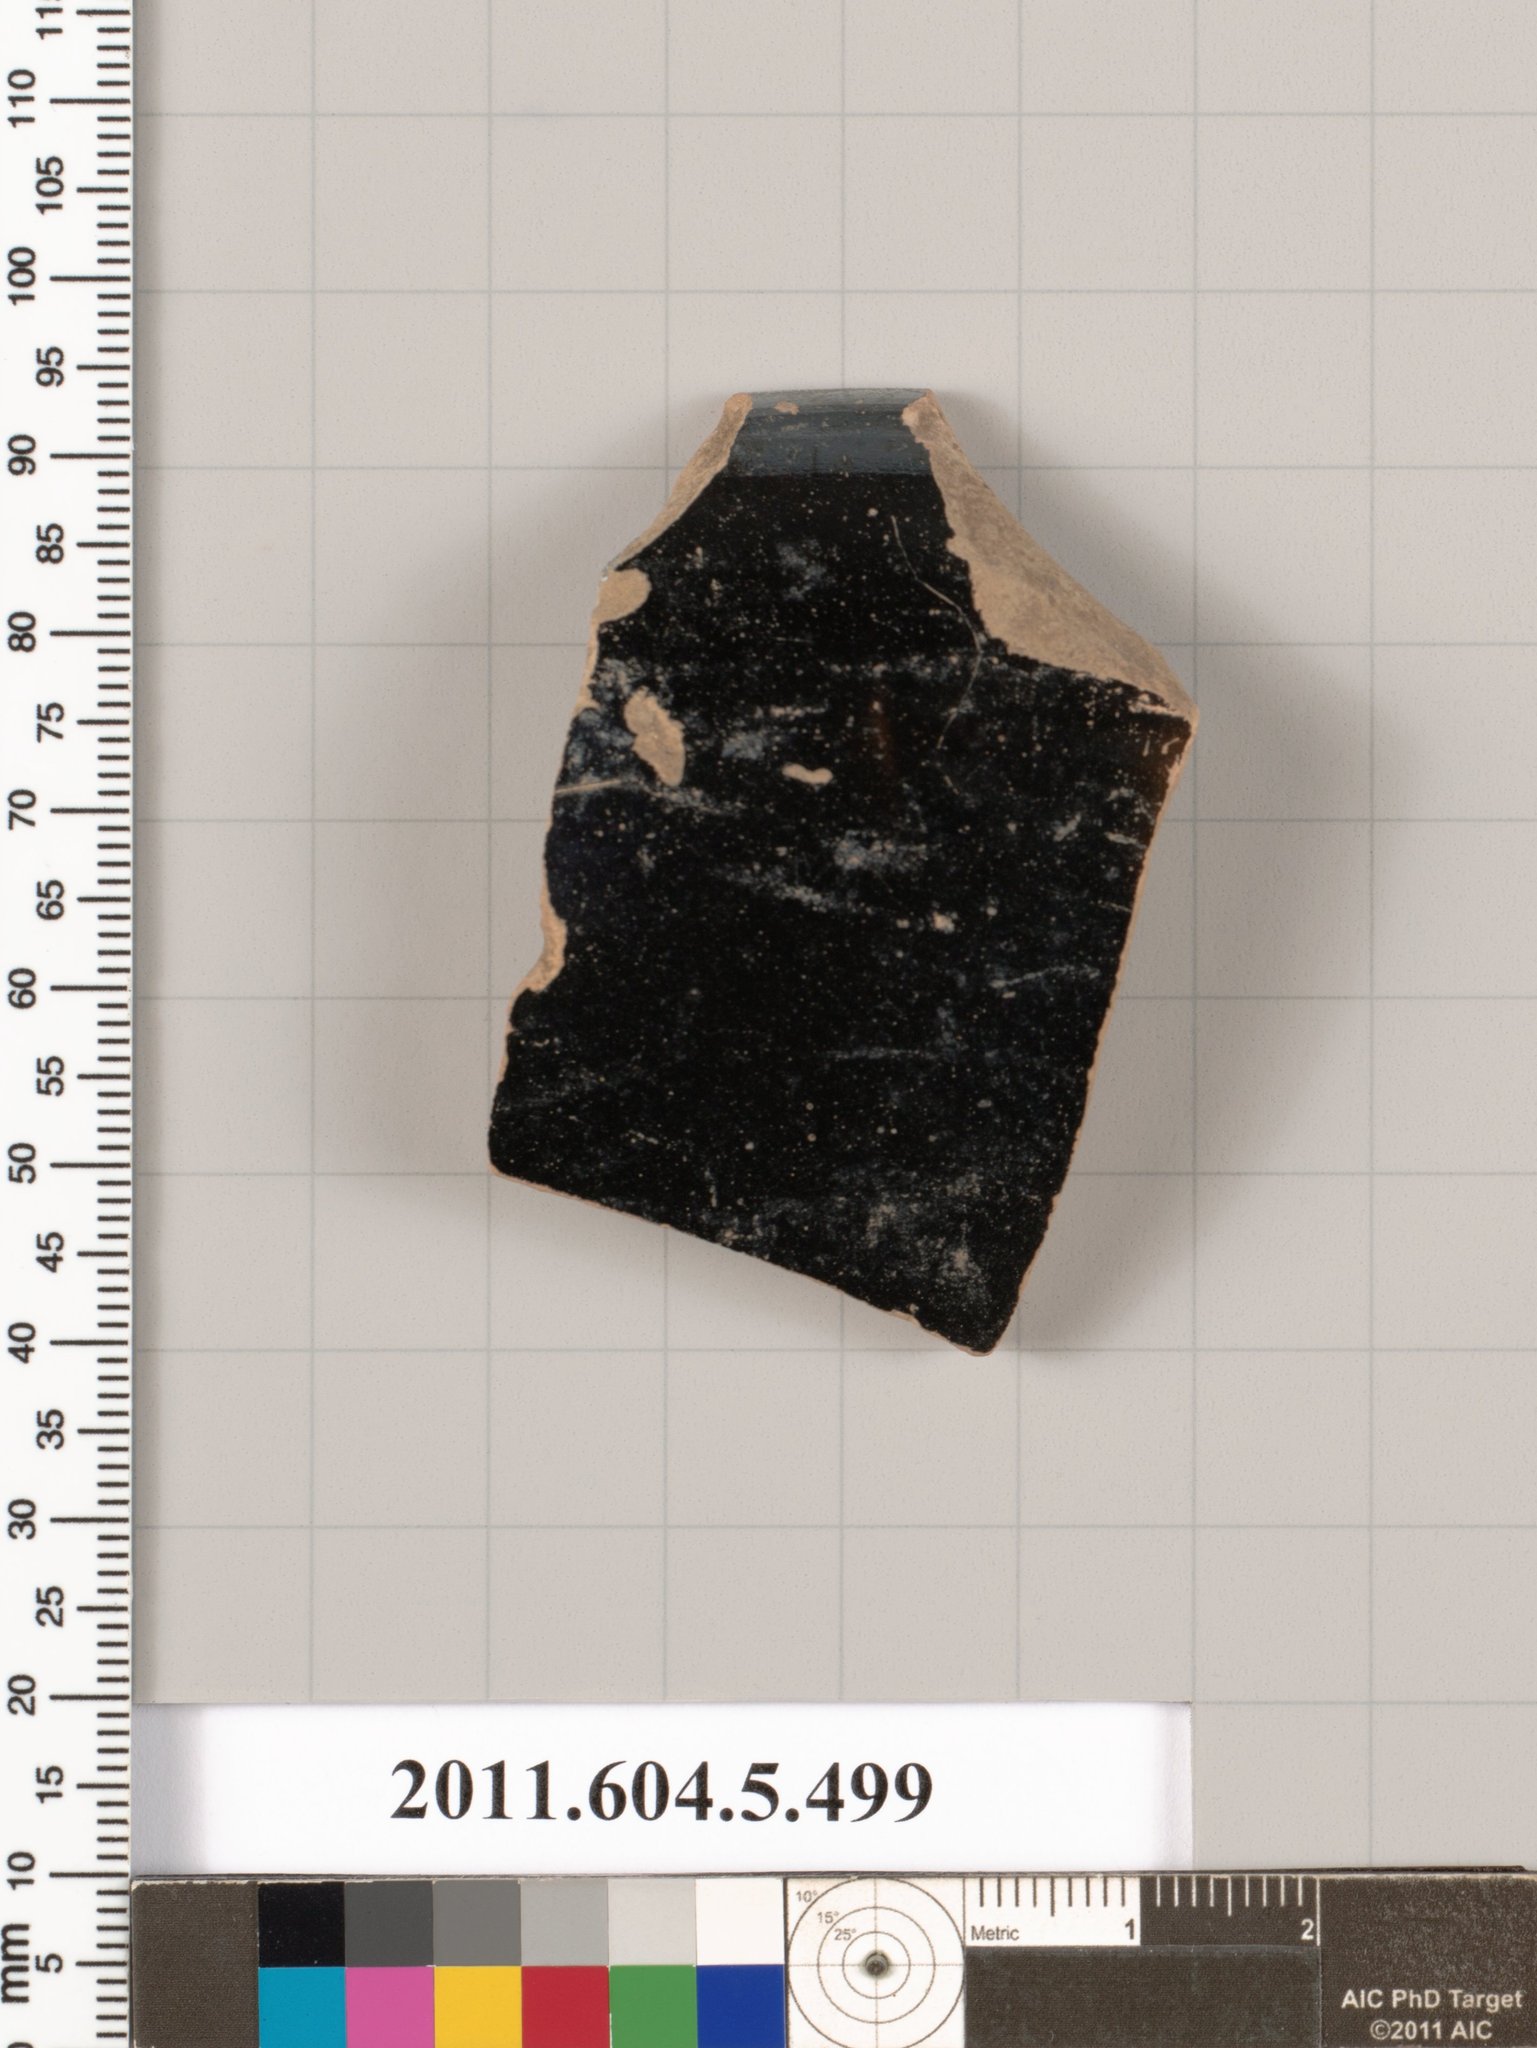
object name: kylix fragment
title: Terracotta rim fragment of a kylix (drinking cup)?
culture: greek, attic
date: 600-401 BCE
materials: terracotta